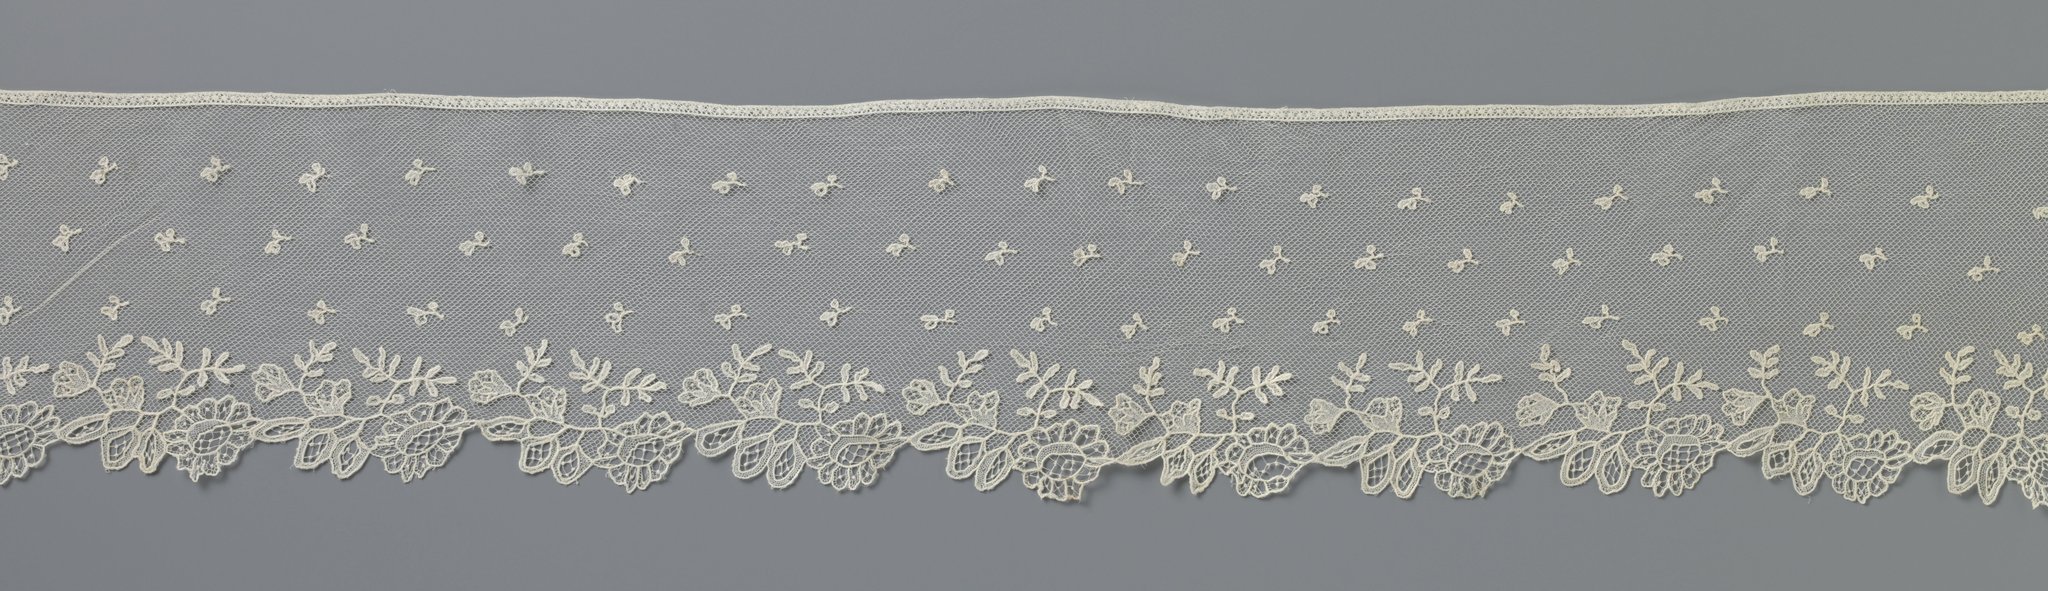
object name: strip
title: Strook applicatiekant met à-jour bloem- en bladtak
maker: Anonymous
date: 1840-1850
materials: linen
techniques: lace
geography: brussels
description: Strook naturelkleurige applicatiekant: naaldkant geappliceerd op machinale tule. Dit type kant staat ook bekend onder de naam: point d'Angleterre. Een met drie rijen kleine blaadjes bestrooid binnengedeelte wordt afgesloten door ongelijke schulpen, die gevormd zijn door aaneengeschakelde dunnen takken met à-jour (open) gewerkte bloemen en drie bladeren.